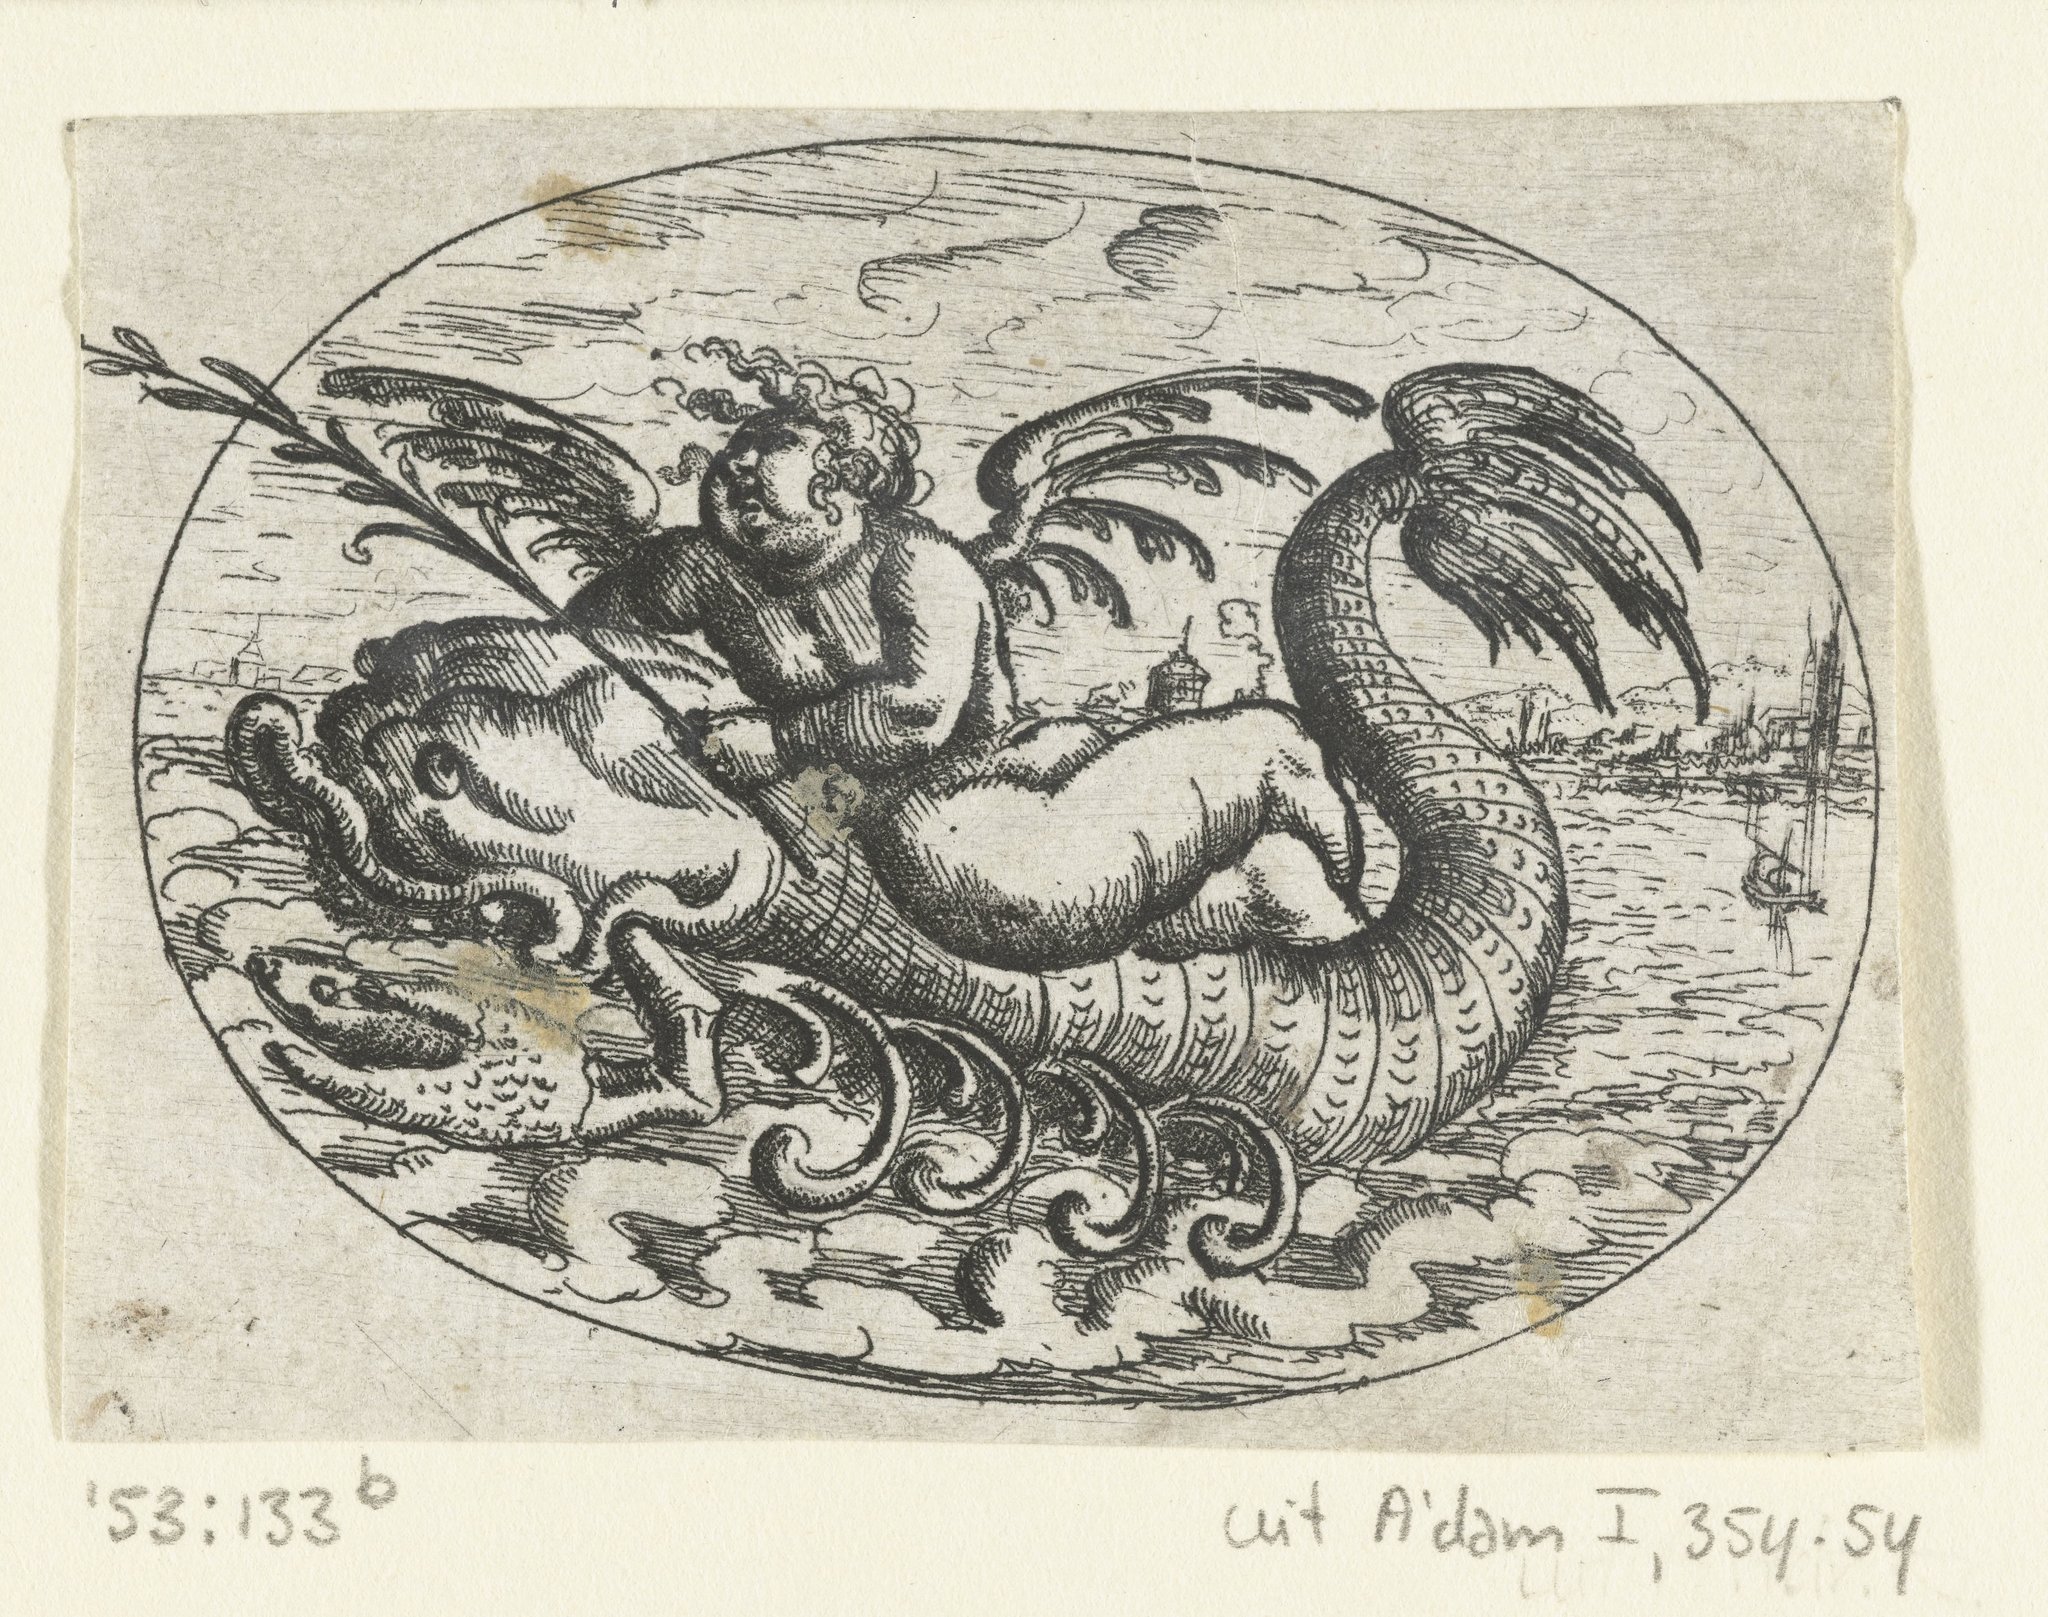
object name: ornament print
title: Liggend ovaal met putto op zeewezen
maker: christoph jamnitzer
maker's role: draughtsman, goldsmith, print maker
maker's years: 1563-1618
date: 1573-1610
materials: paper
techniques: etching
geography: germany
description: Putto met een tak bloemen, liggend op een vis met scharen. Blad uit een serie vlakdecoraties met grotesken, cartouches, ovalen, mascarons, putti en fantastische wezens. De serie bestaat uit drie titelbladen, twee tekstbladen met de opdracht en het voorwoord en 60 bladen, verdeeld over drie boeken.